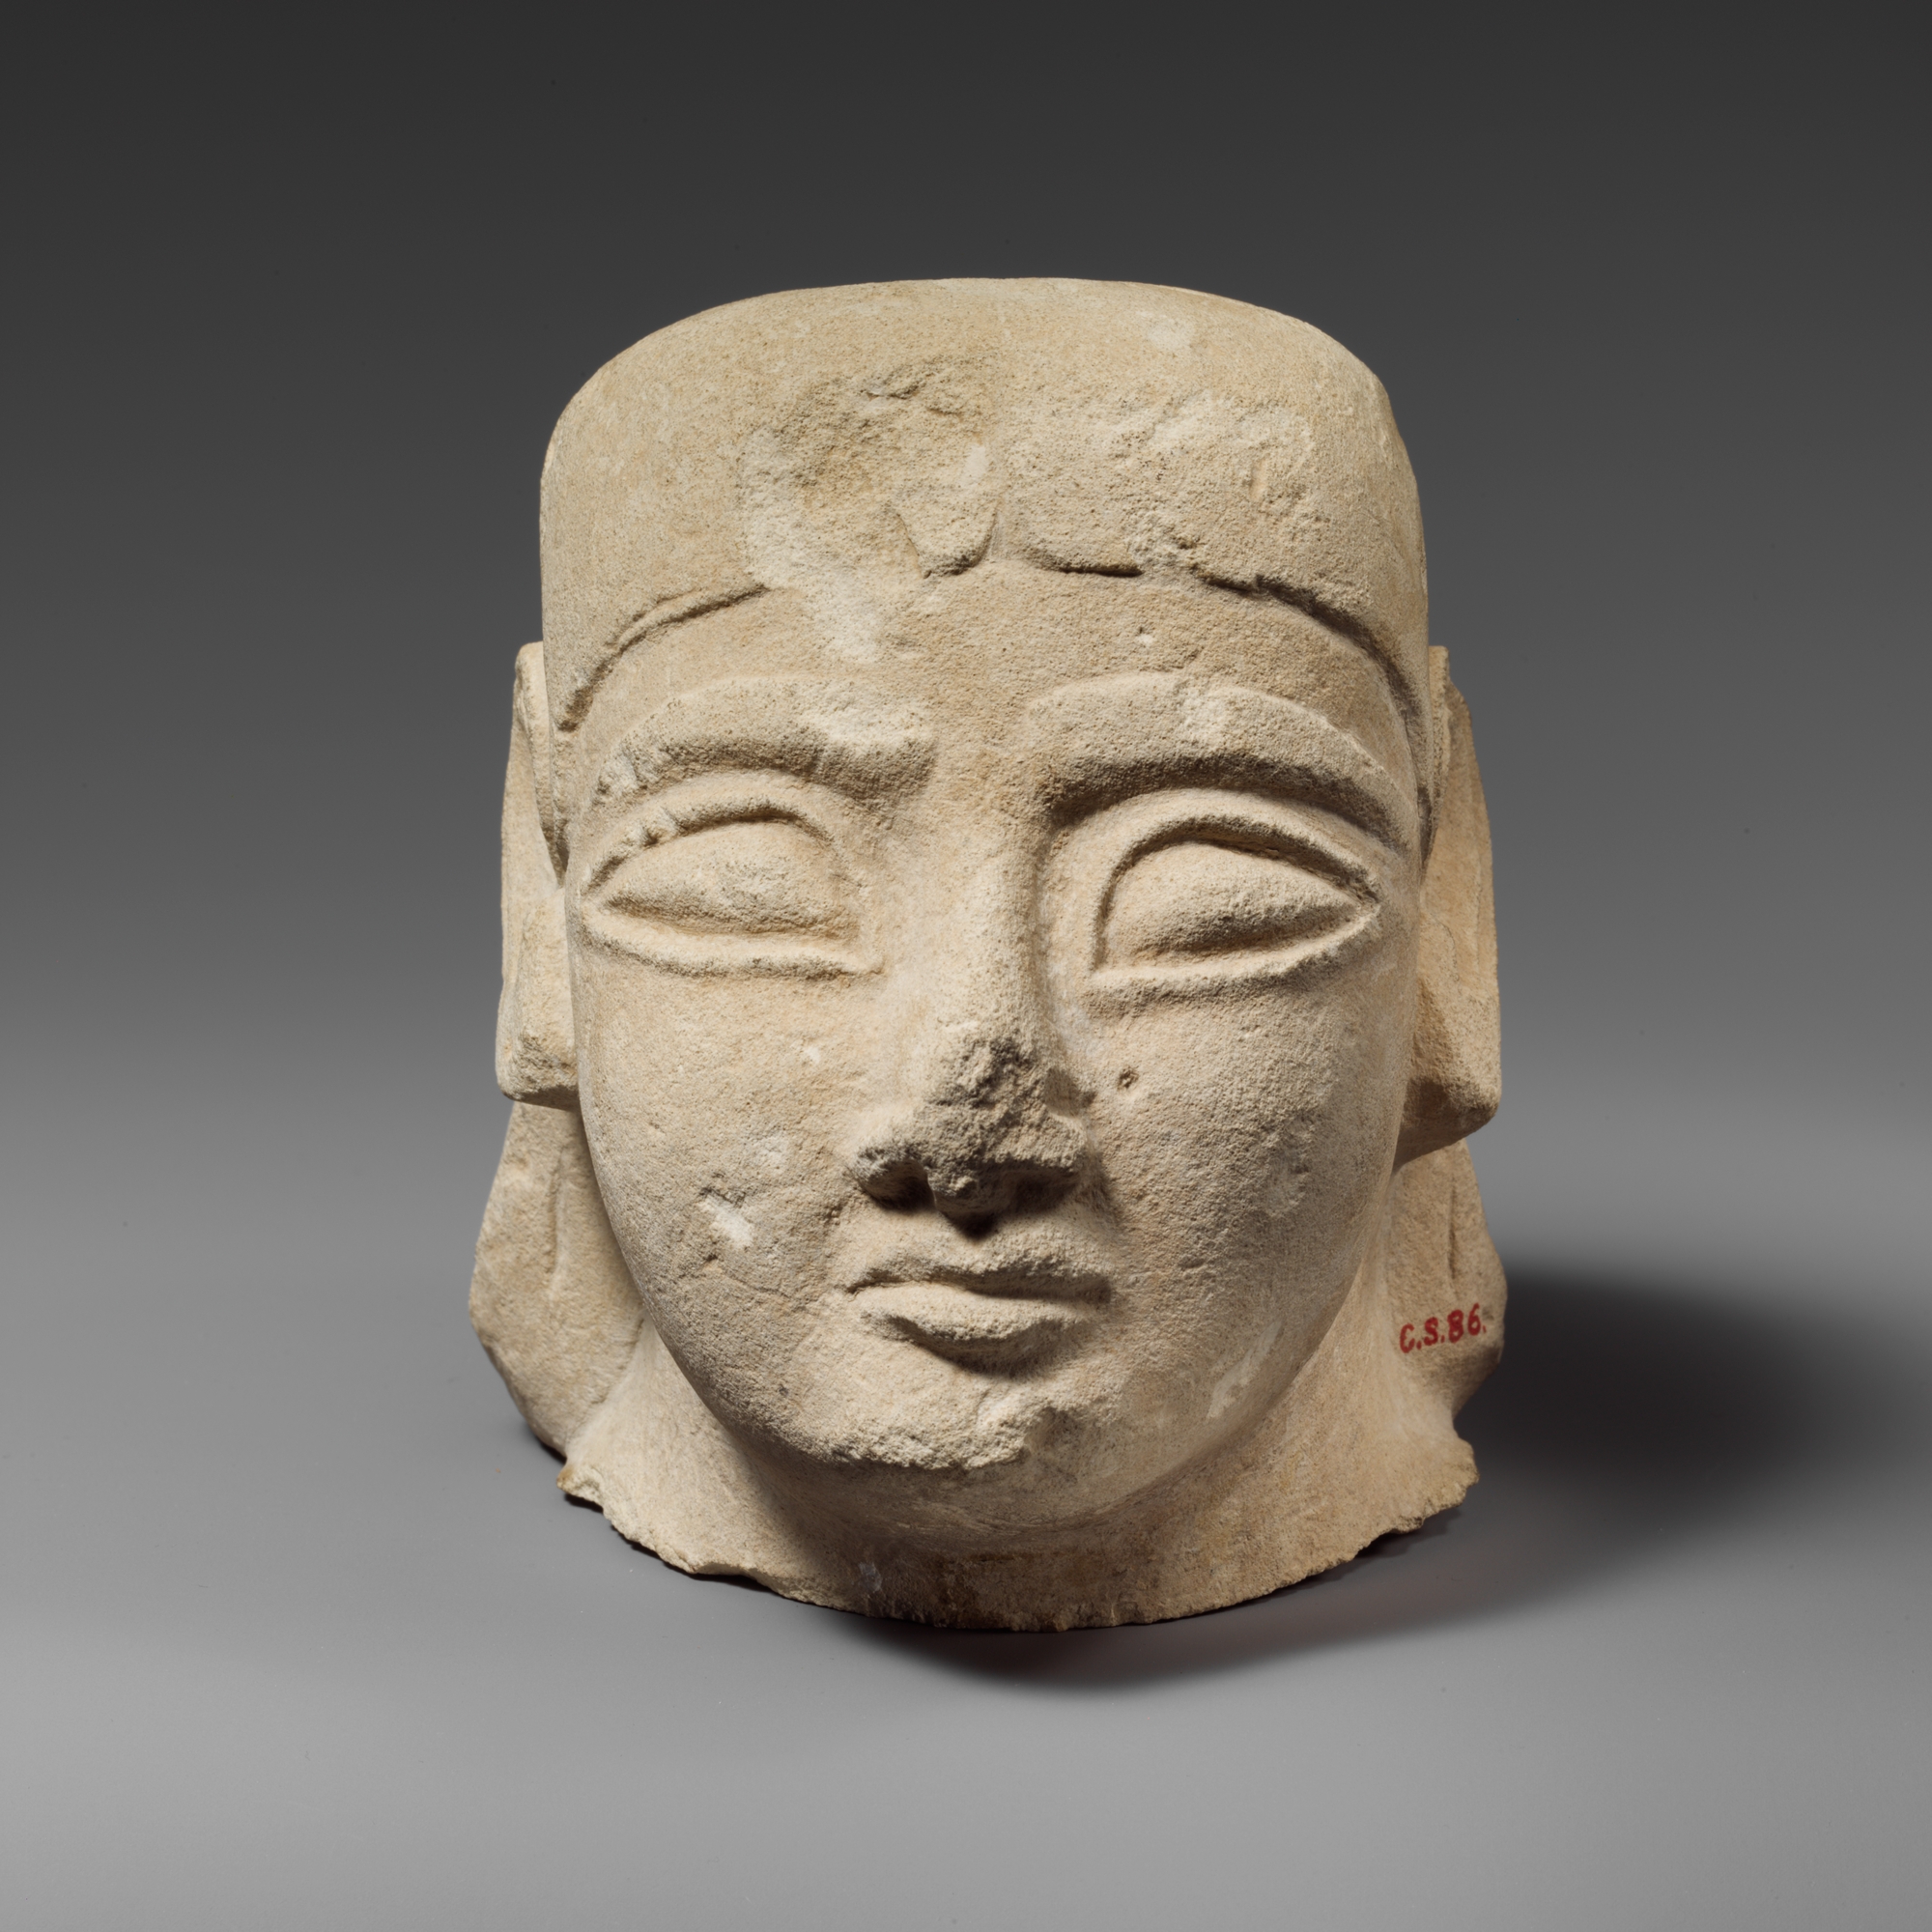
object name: head of a votary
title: Limestone head of a beardless male with a plain headdress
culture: cypriot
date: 600-551 BCE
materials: limestone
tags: heads,men